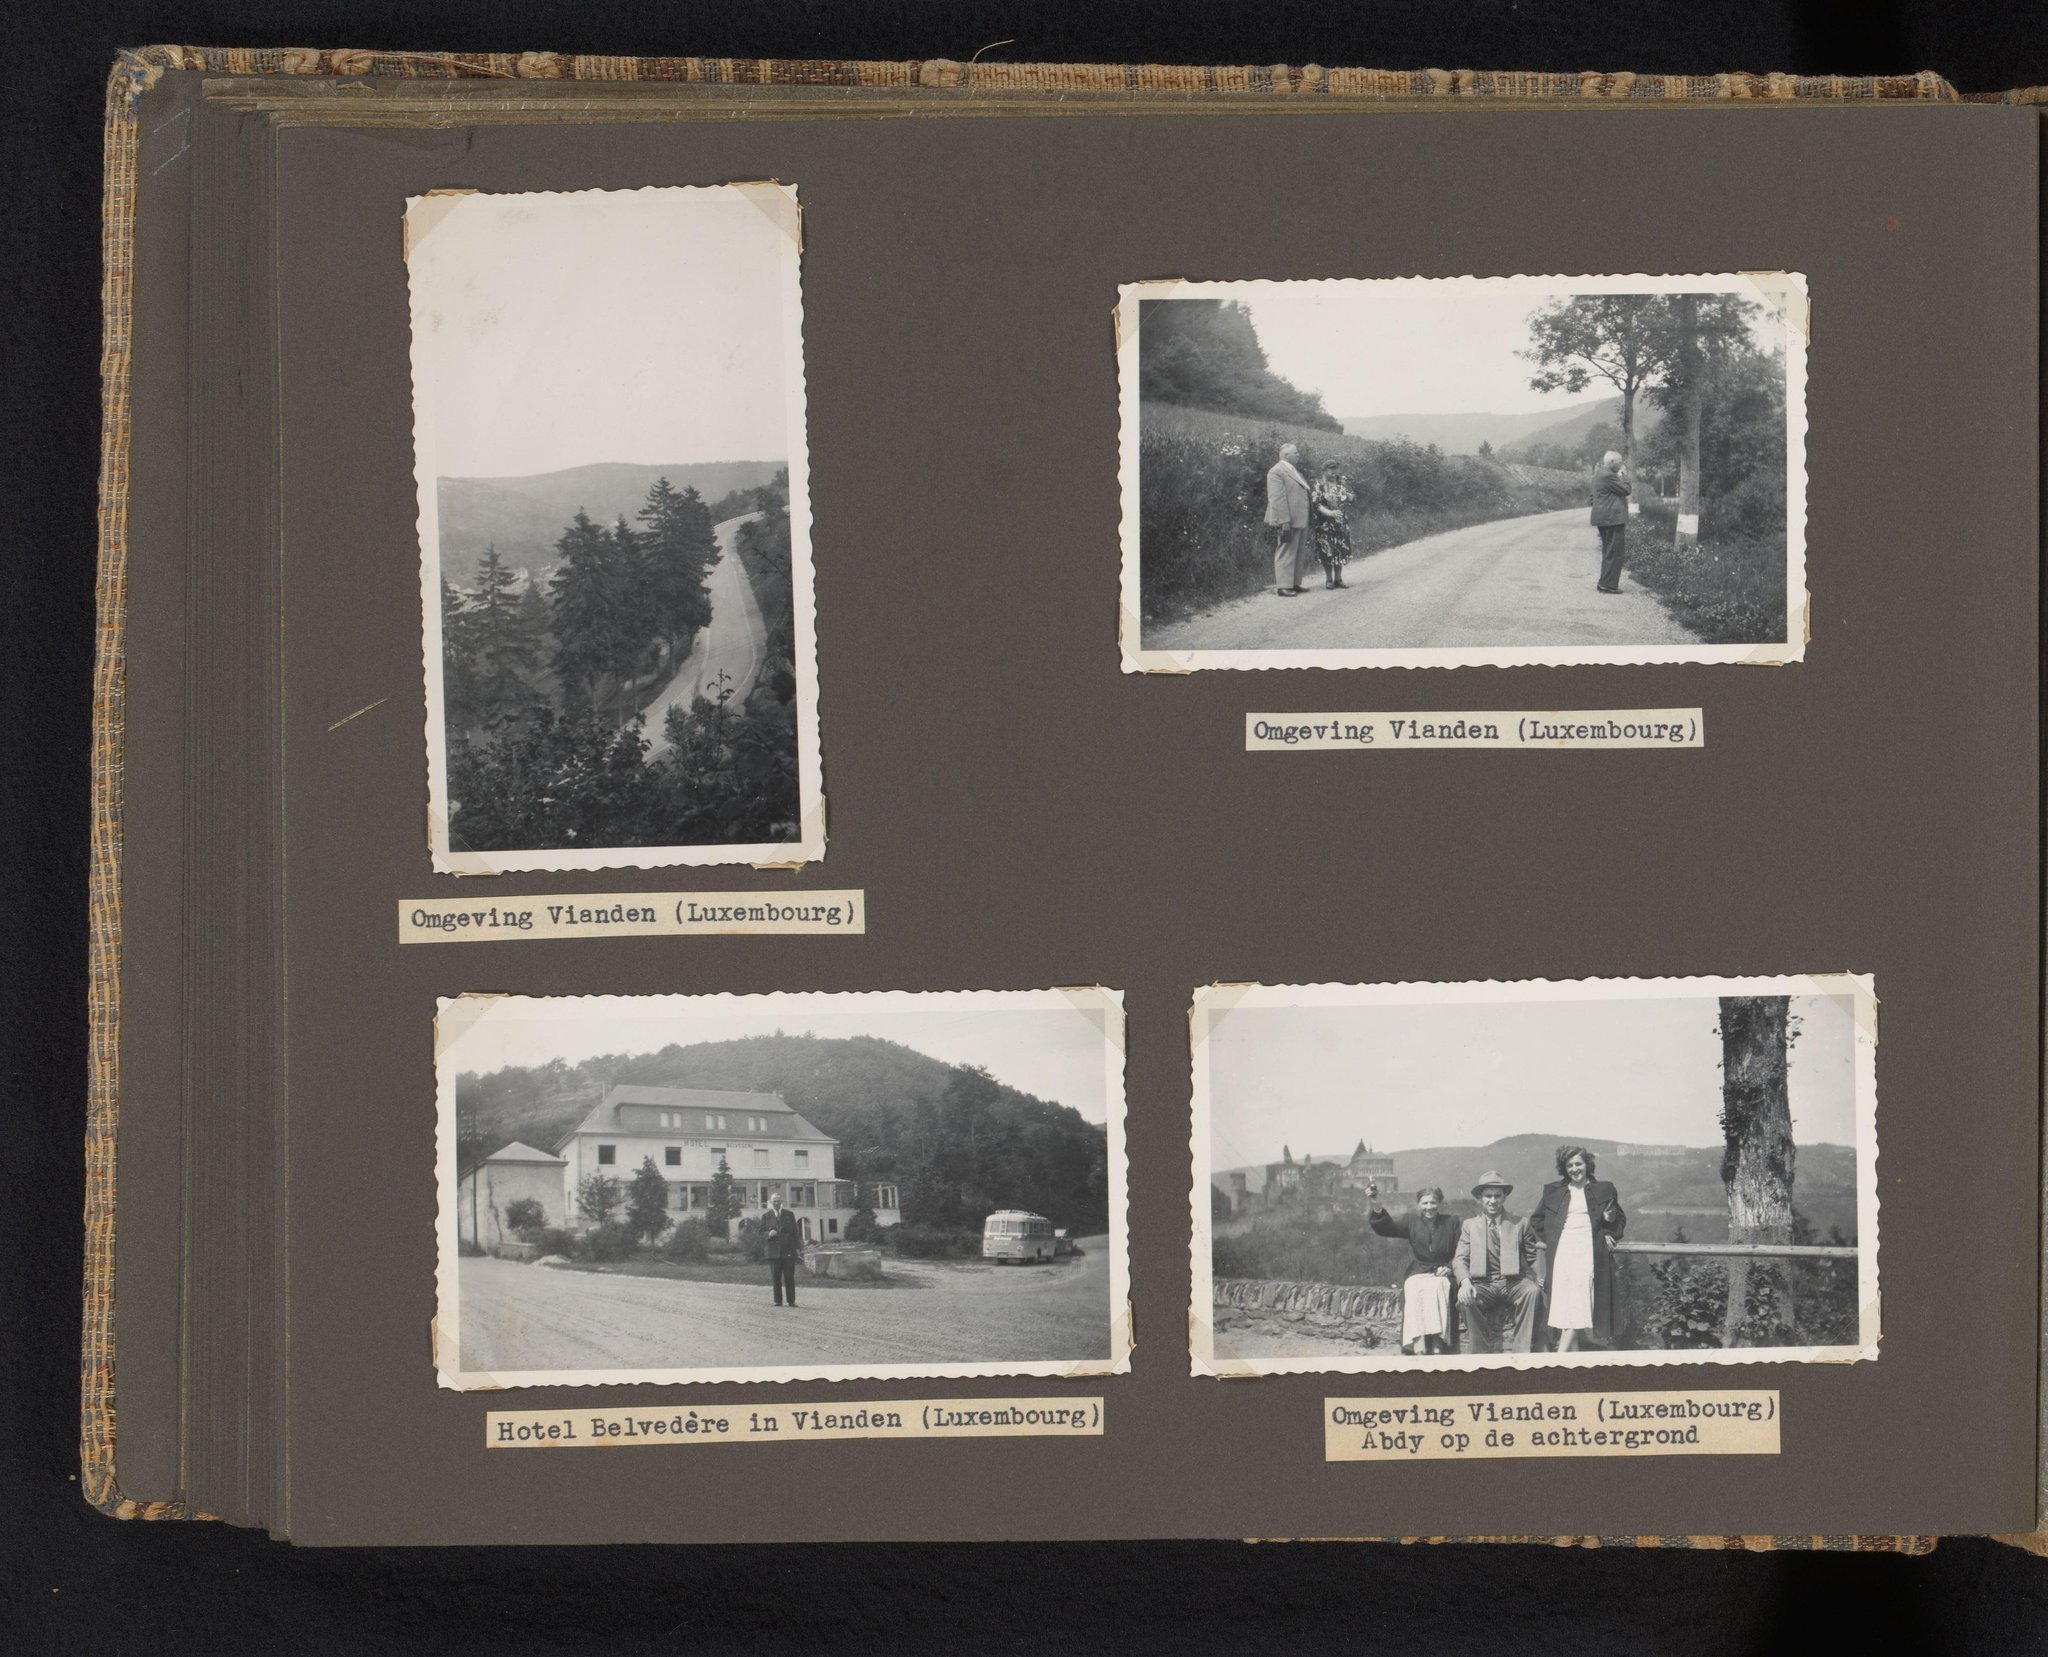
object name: album leaf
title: Vianden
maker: Anonymous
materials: paper, photographic support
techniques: gelatin silver print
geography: belgium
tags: bus, coach, low hill country, the family travelling, on holiday, outing, pleasure trip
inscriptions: inscription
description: Albumblad met vier foto's van de omgeving van Vianden in Luxemburg. Onder de foto's uitgeknipte papiertjes met getypte opschriften. Onderdeel van het eerste fotoalbum met foto's van de twee fietstochten van vader en zoon door Nederland in september 1939 en juli 1940 en een autotrip met het gezin door Nederland, België en Luxemburg in juni 1949.